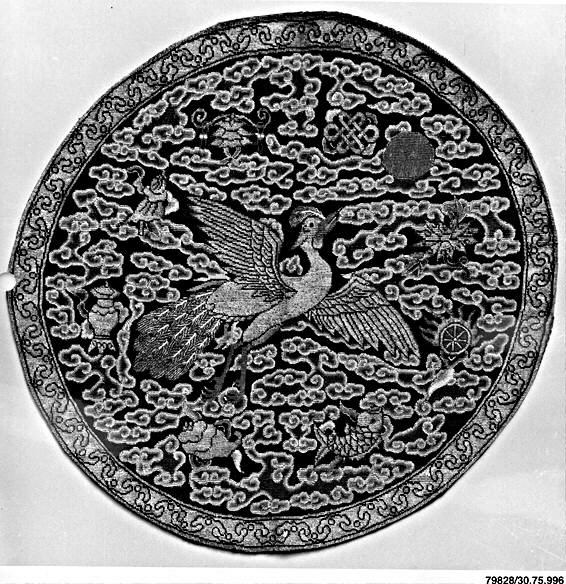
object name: insignia medallion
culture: chinese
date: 1801-1900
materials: metal thread, silk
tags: birds